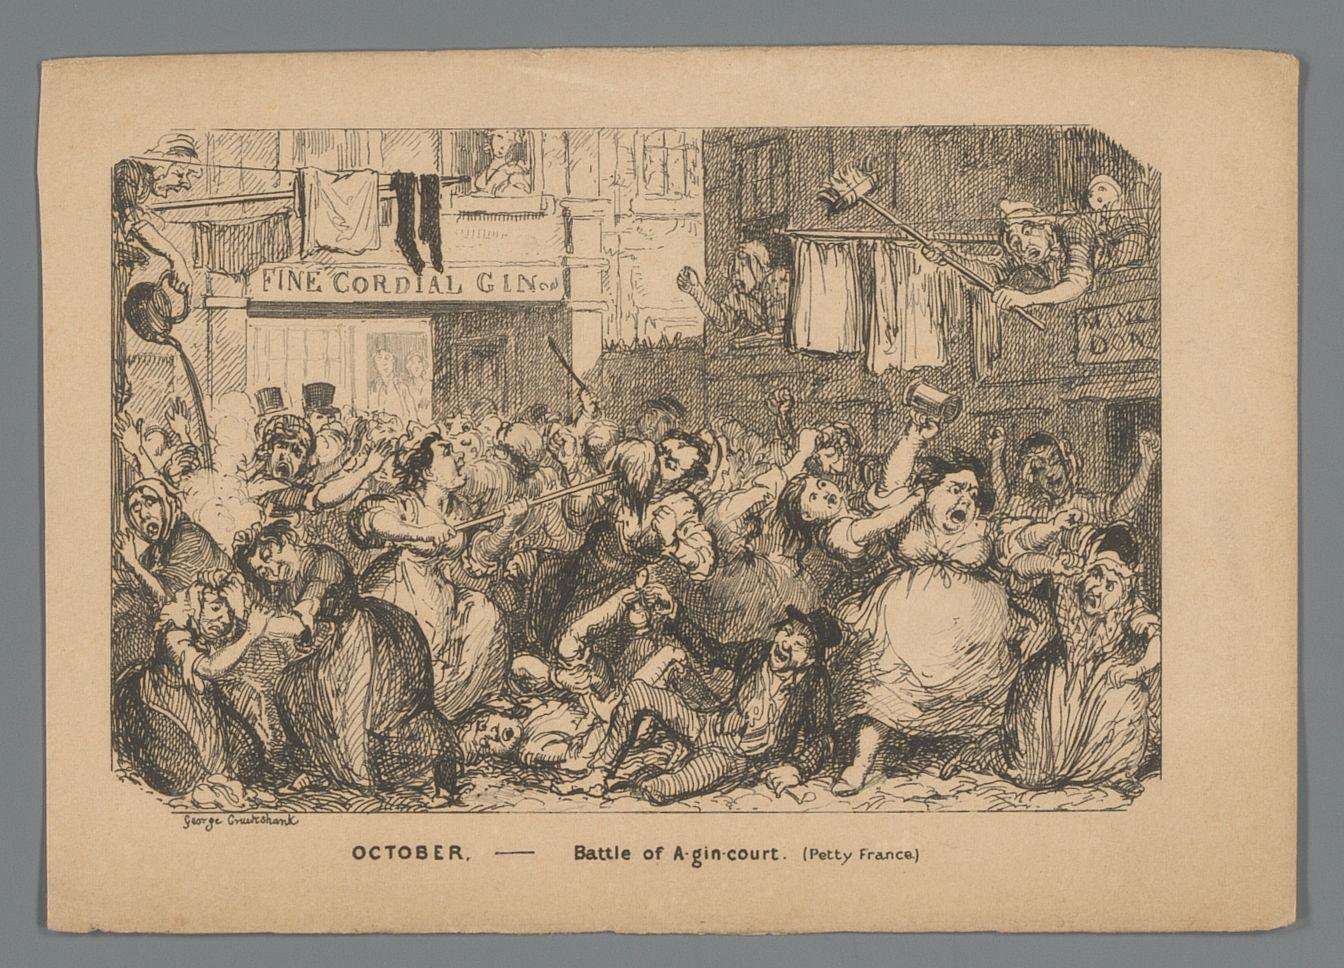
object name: book illustration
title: Oktober: straatruzie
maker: george cruikshank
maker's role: painter, print maker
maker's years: 1792-1878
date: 1838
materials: paper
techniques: etching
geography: england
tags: october; 'ottobre' (ripa), drunken brawl (usually peasants fighting in an inn), political caricatures and satires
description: Gevecht en dronkenschap op straat voor een drankwinkel. Illustratie voor de maand oktober uit een uitgave van: The Comic Almanack (1838).